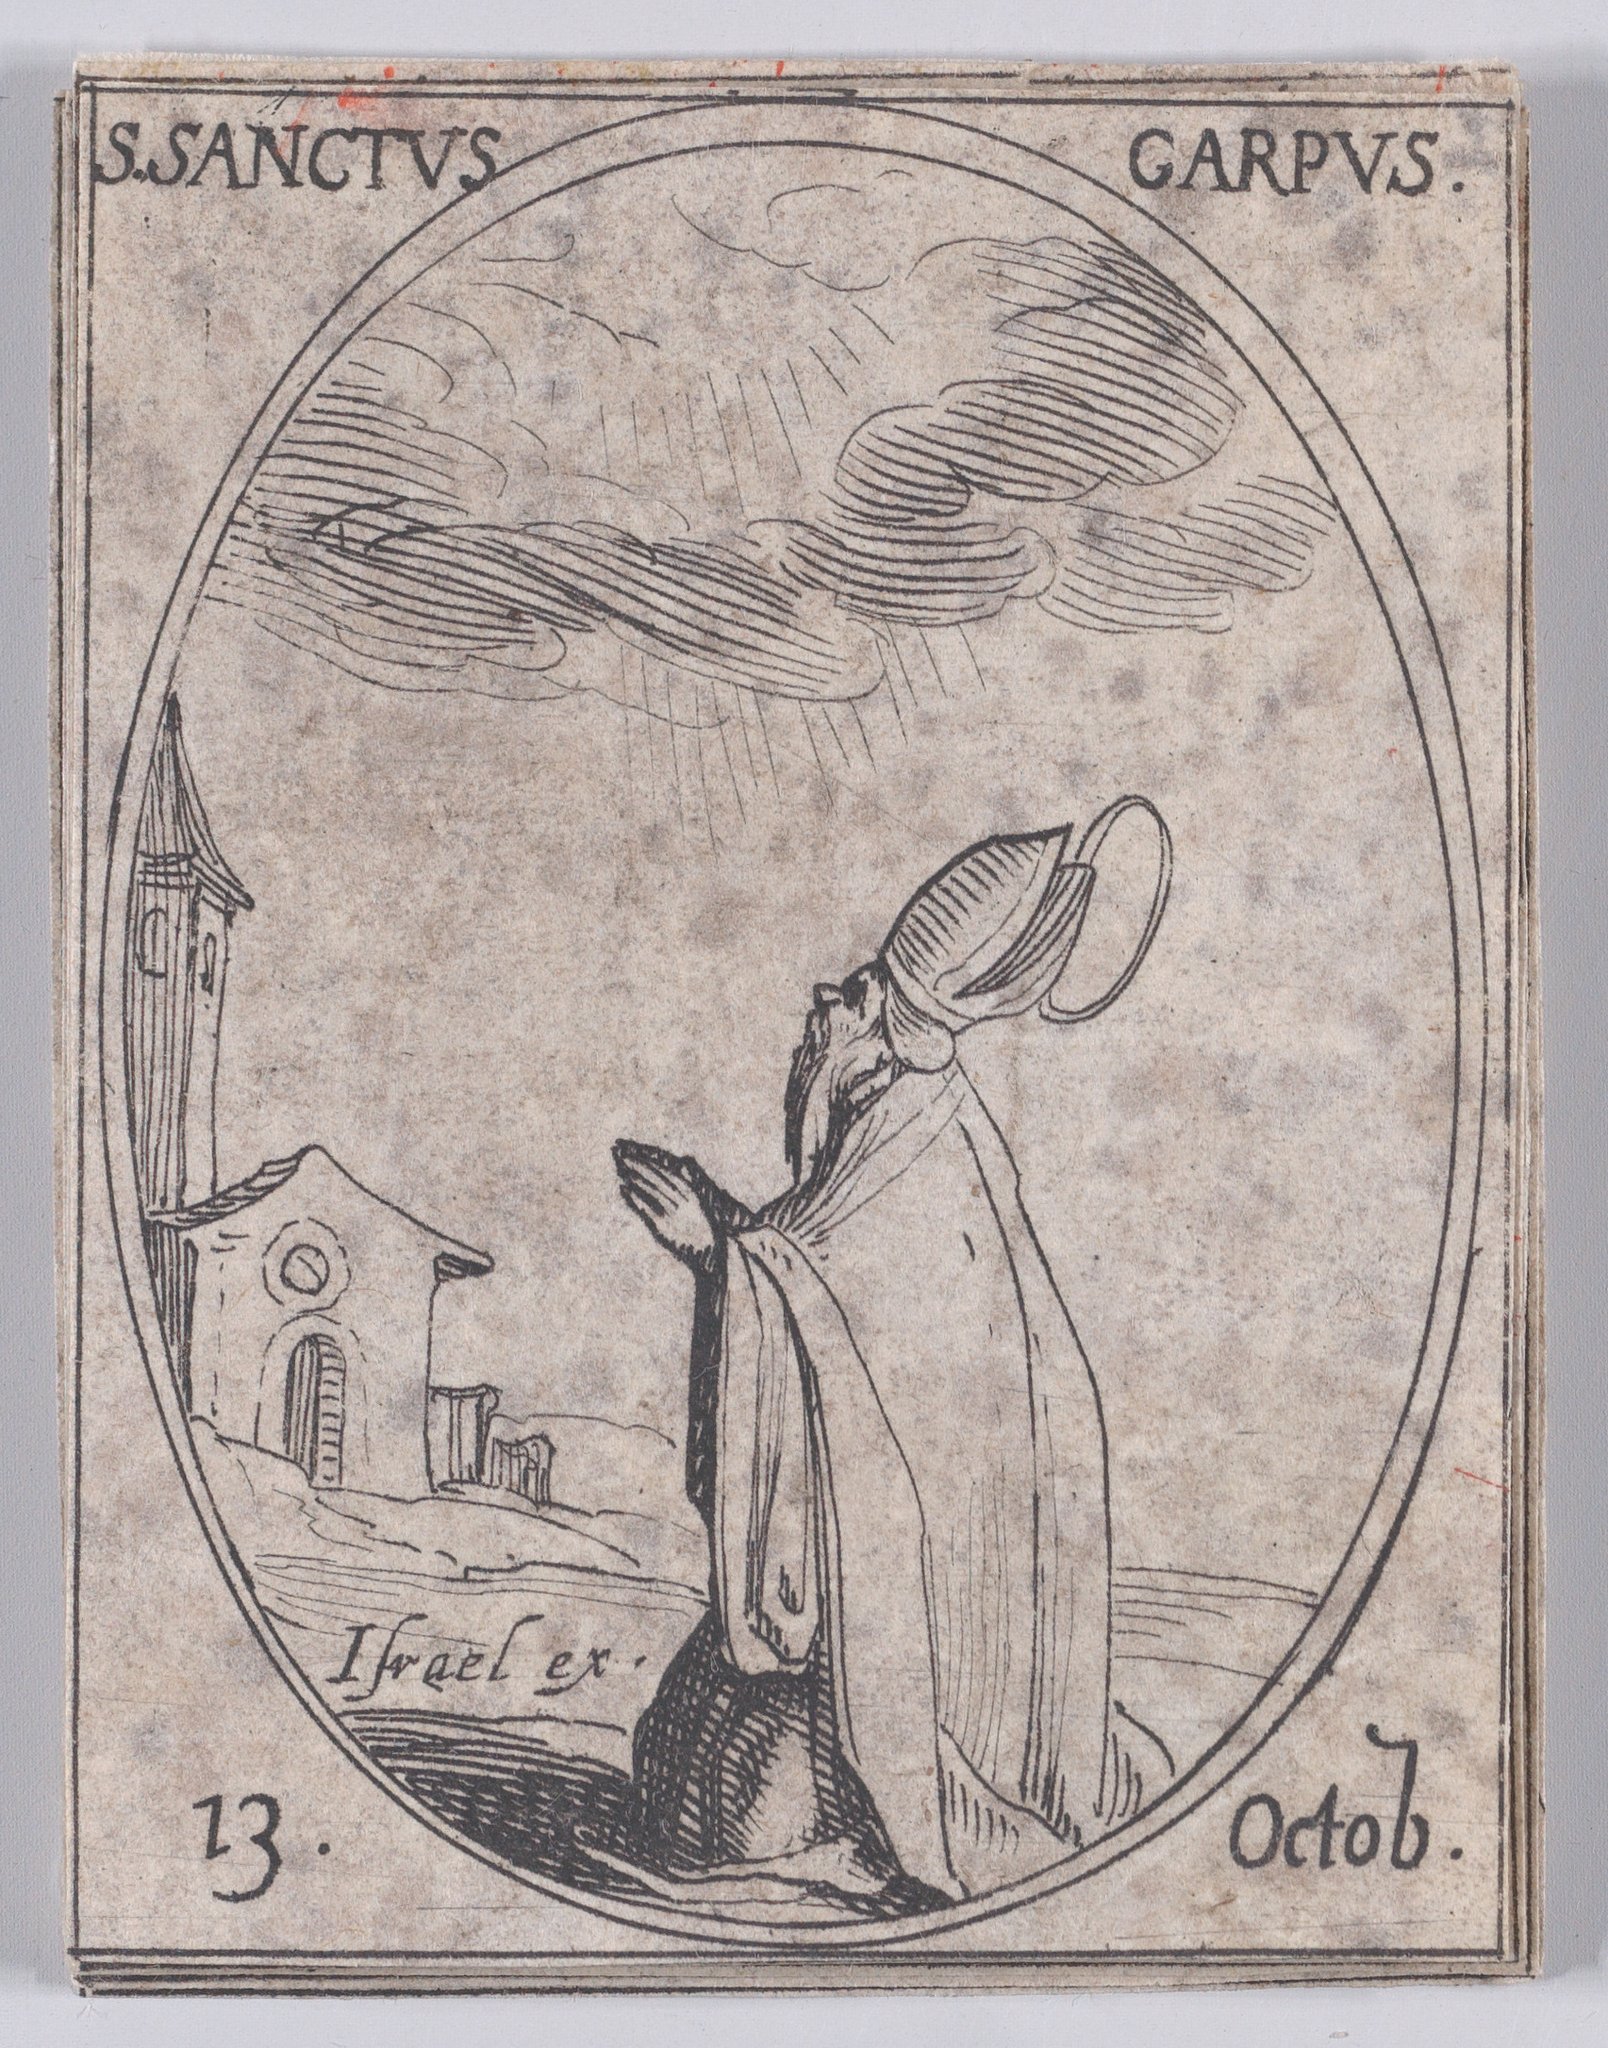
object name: print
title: S. Carpe (St. Carpus), October 13th, from "Les Images De Tous Les Saincts et Saintes de L'Année" (Images of All of the Saints and Religious Events of the Year)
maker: jacques callot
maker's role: artist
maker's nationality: french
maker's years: 1592-1635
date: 1636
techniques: etching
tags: men,saints